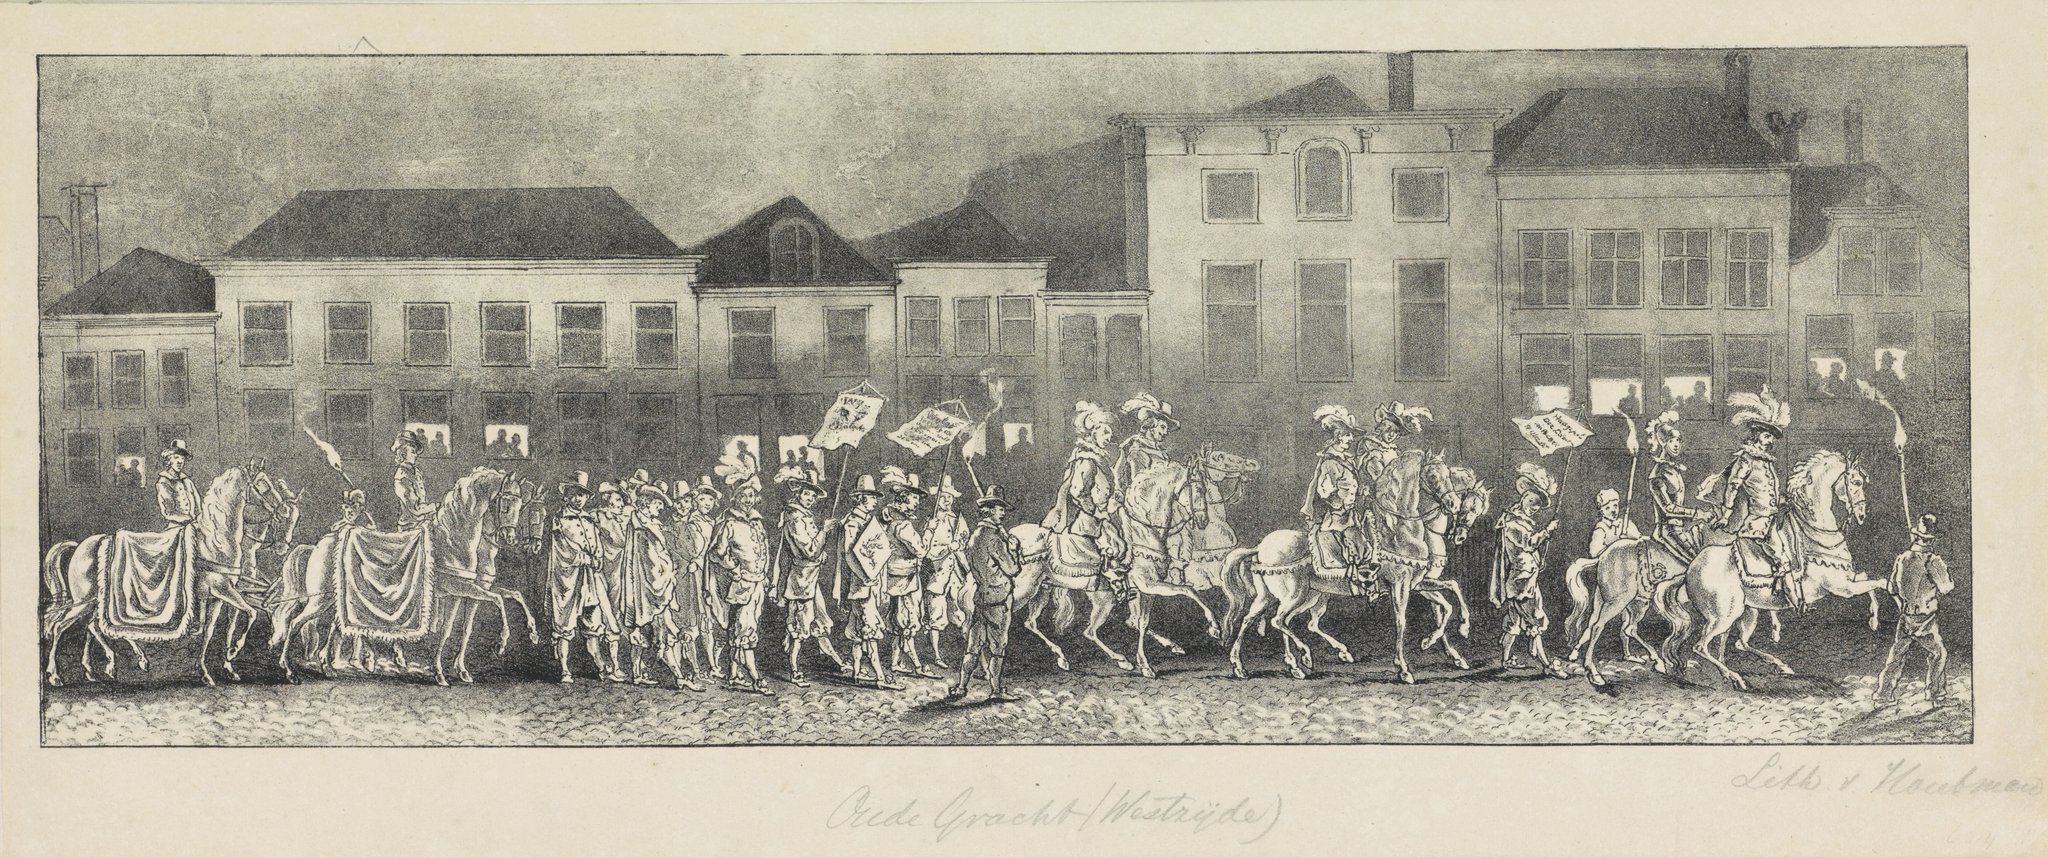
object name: print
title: Optocht in maskerade (plaat 1), 1829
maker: johannes paulus houtman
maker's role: bookseller, print maker, printer, publisher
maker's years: 1803-1845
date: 1829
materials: paper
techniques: lithograph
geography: netherlands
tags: students' pageant, masquerade, masked ball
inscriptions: collector's mark: Lugt 2228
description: Optocht in maskerade van Utrechtse studenten ter viering van de Dies Natalis van de universiteit van Utrecht op 26 maart 1829. Plaat 1: Het begin van de stoet ruiters en voetvolk met brandende toortsen op de westzijde van de Oudegracht. Onderdeel van een groep van zeven platen die samen een lange fries vormen.